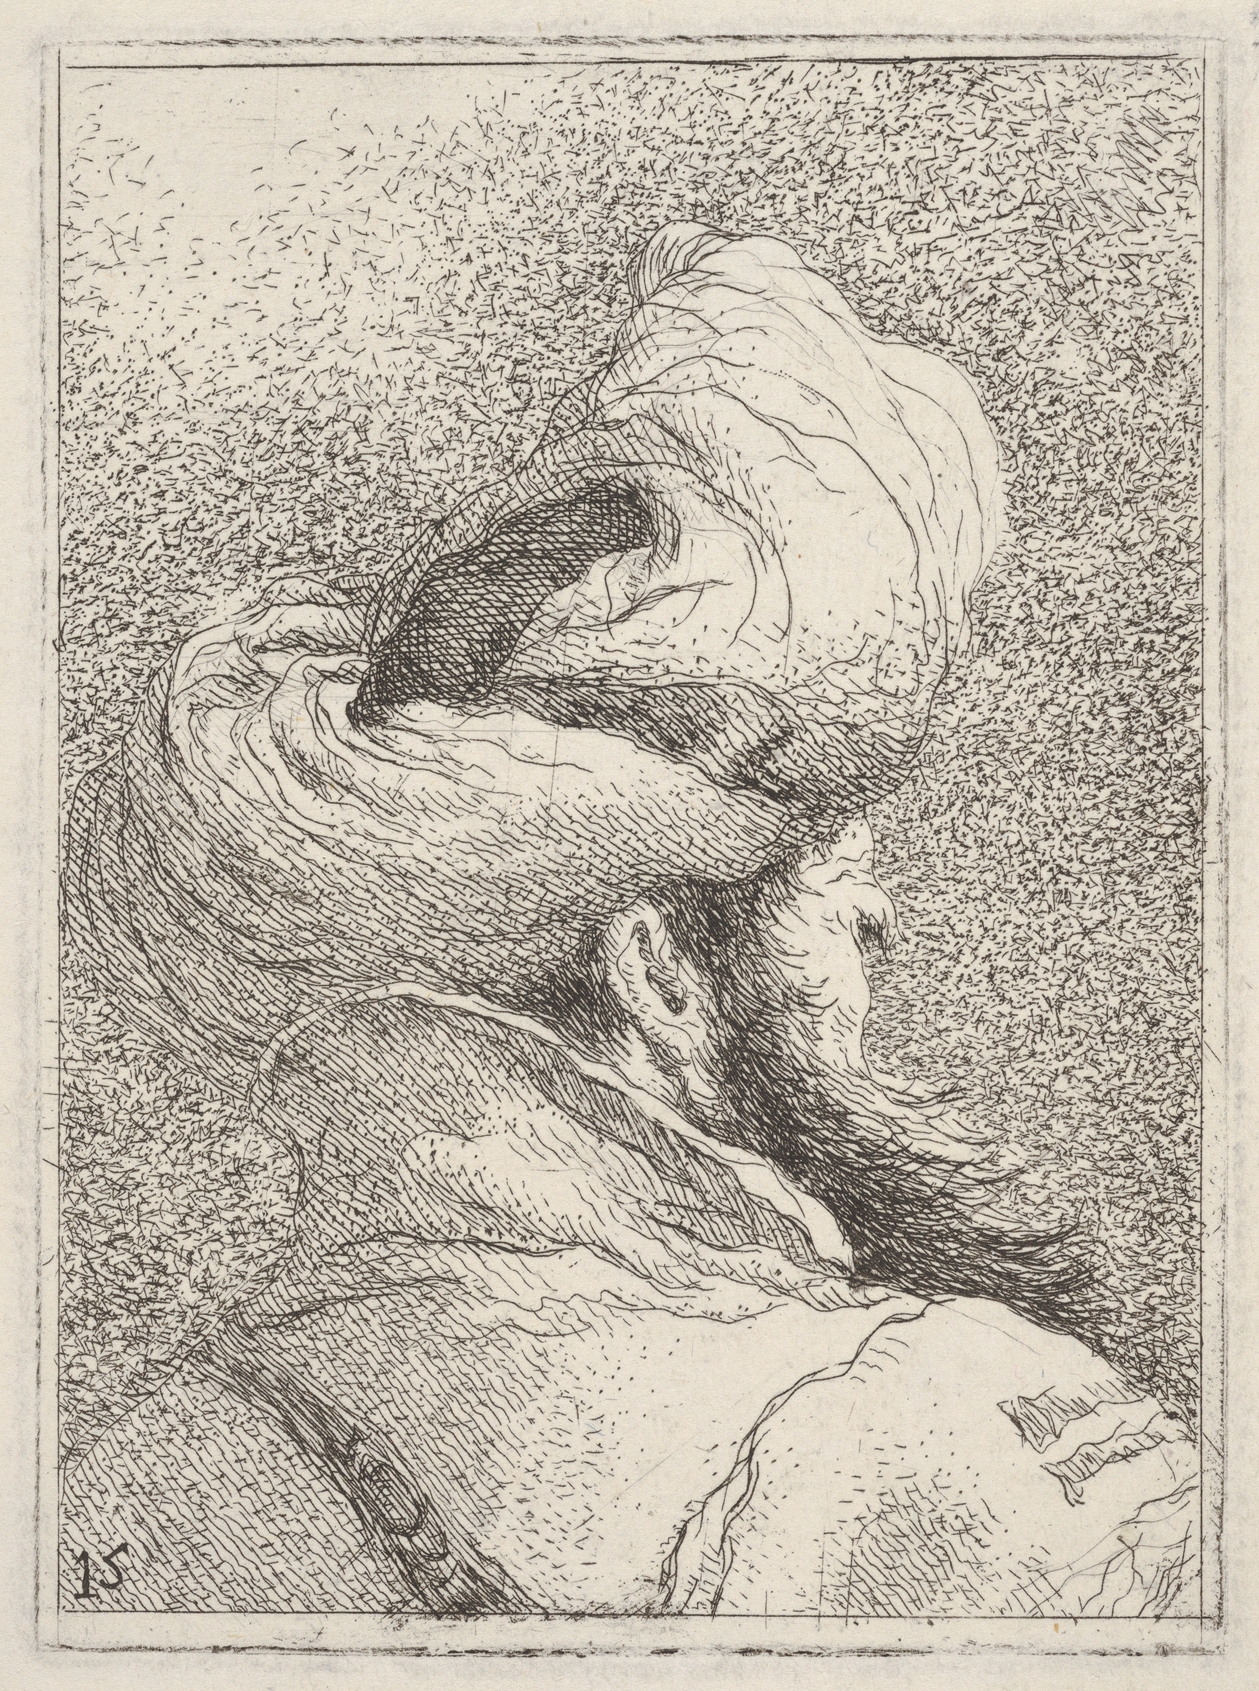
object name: print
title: Bearded man wearing a turban, depicted in bust length from behind in three-quarters view, from "Collection of heads" (Raccolta di teste)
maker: giovanni domenico tiepolo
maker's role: artist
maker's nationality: italian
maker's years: 1727-1804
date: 1770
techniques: etching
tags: men